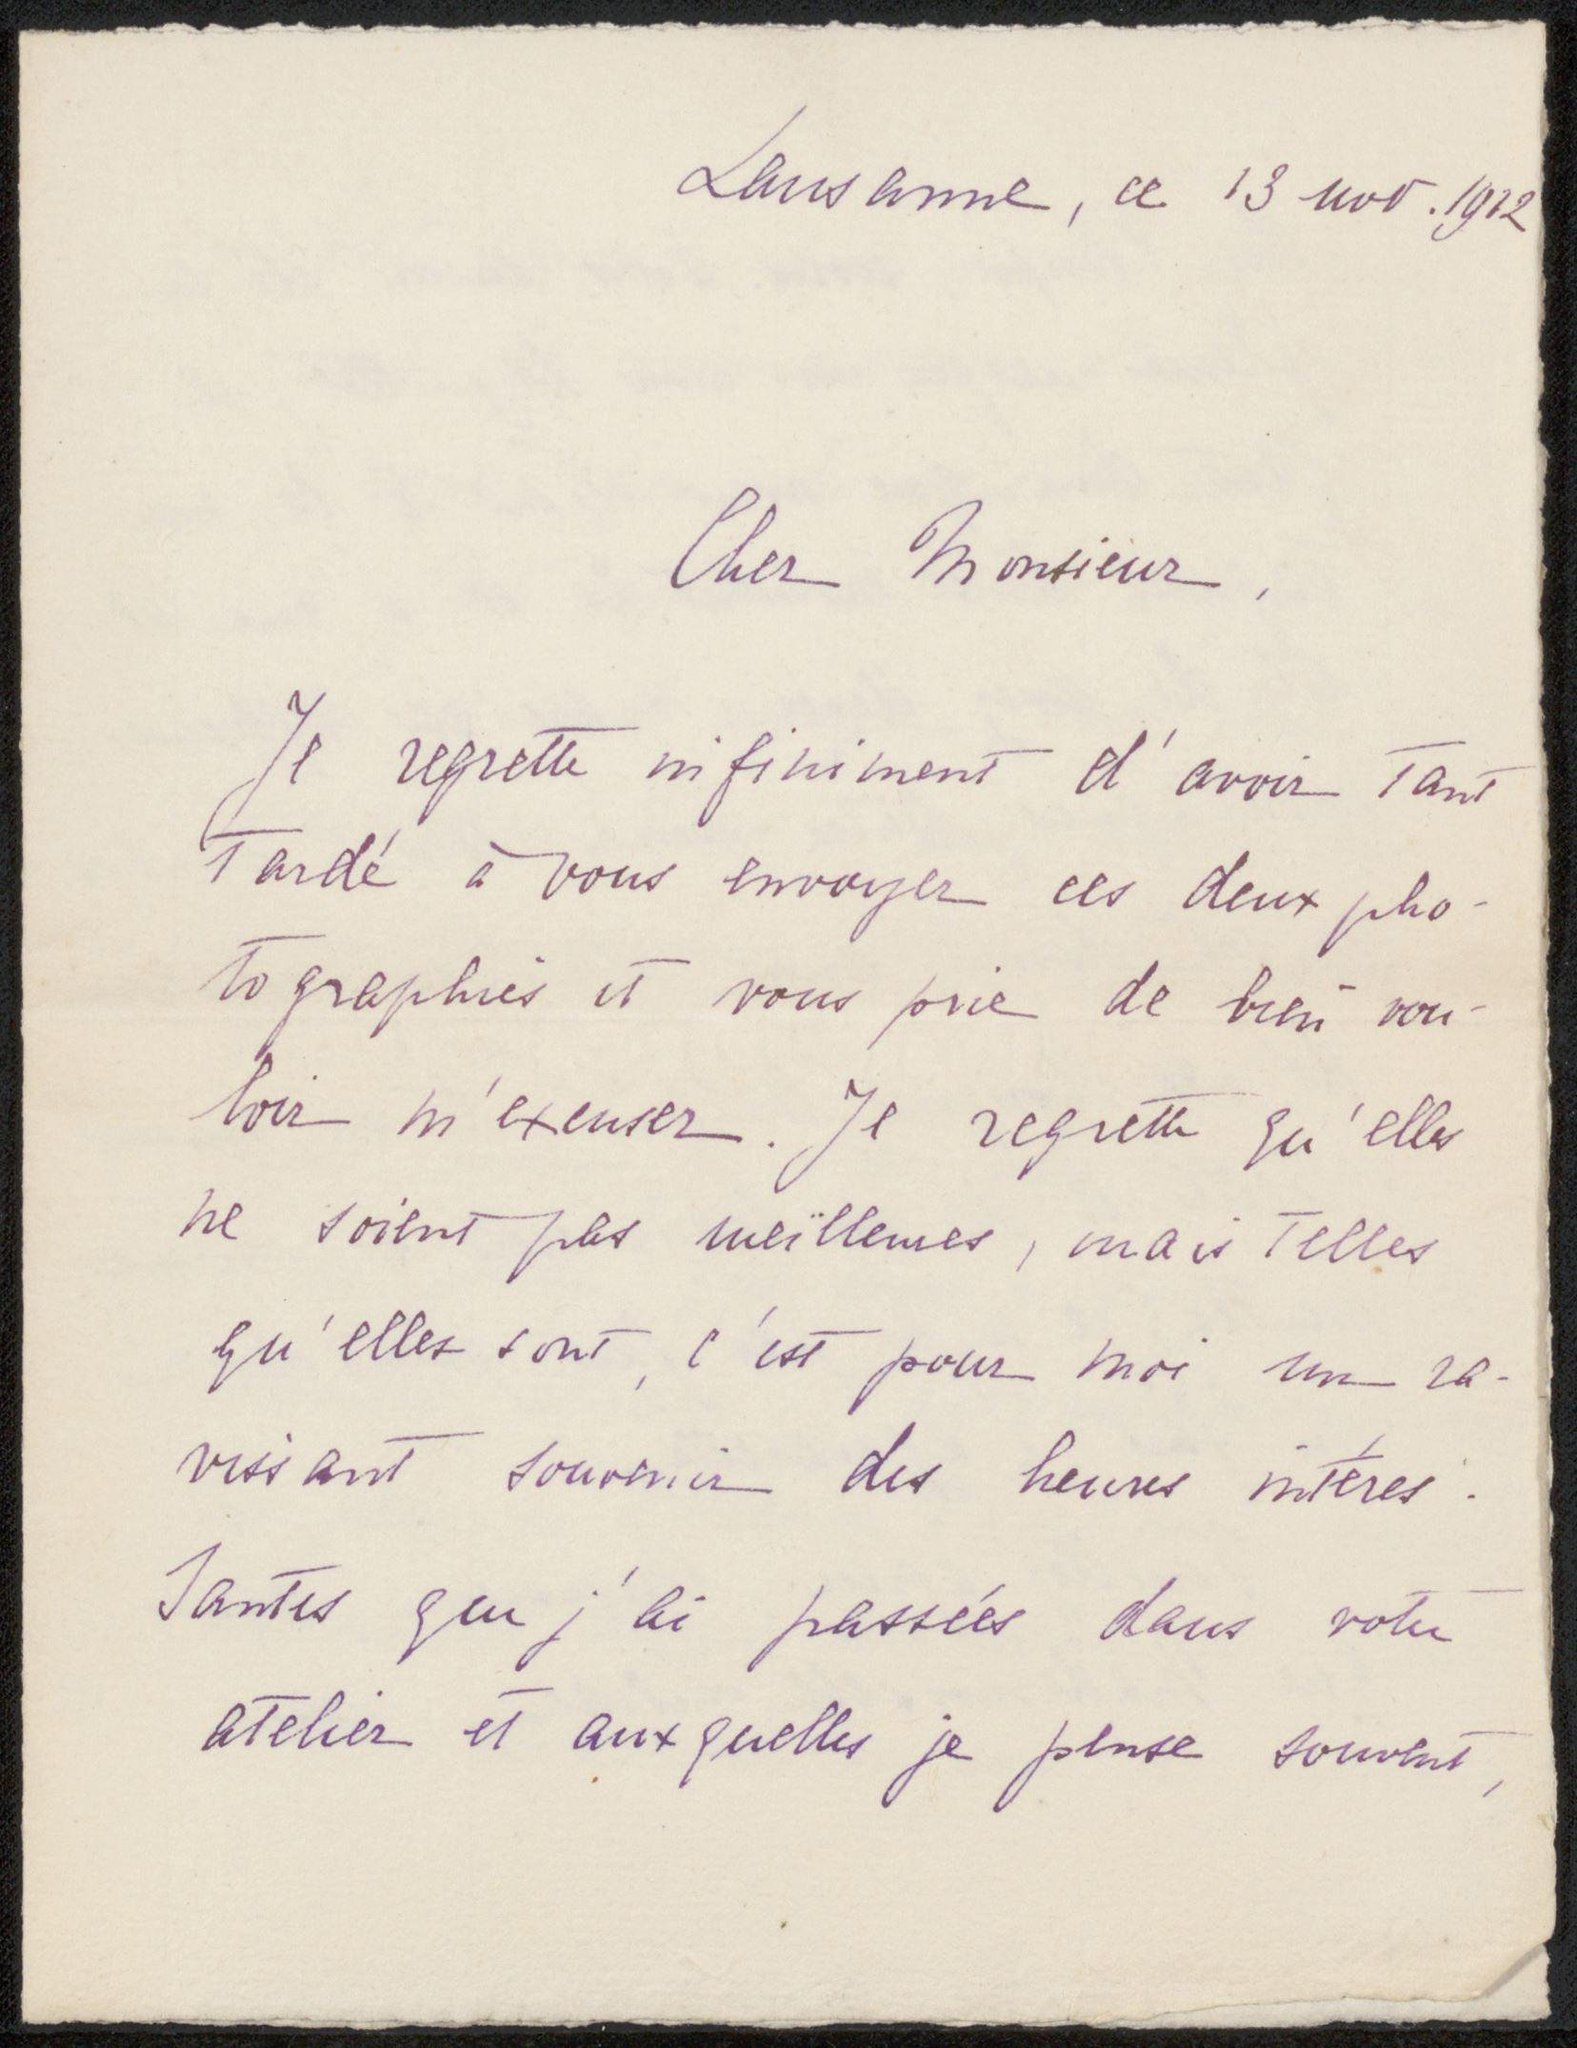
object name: letter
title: Brief aan Philip Zilcken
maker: m. secretan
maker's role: schrijver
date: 1912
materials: ink, paper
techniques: pen, writing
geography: lausanne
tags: the hague, painter, philip zilcken, photography, cinematography, travelling; tourism, workshop, studio of the artist (in general), diseases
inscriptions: collector's mark: ‘RPK’, watermark